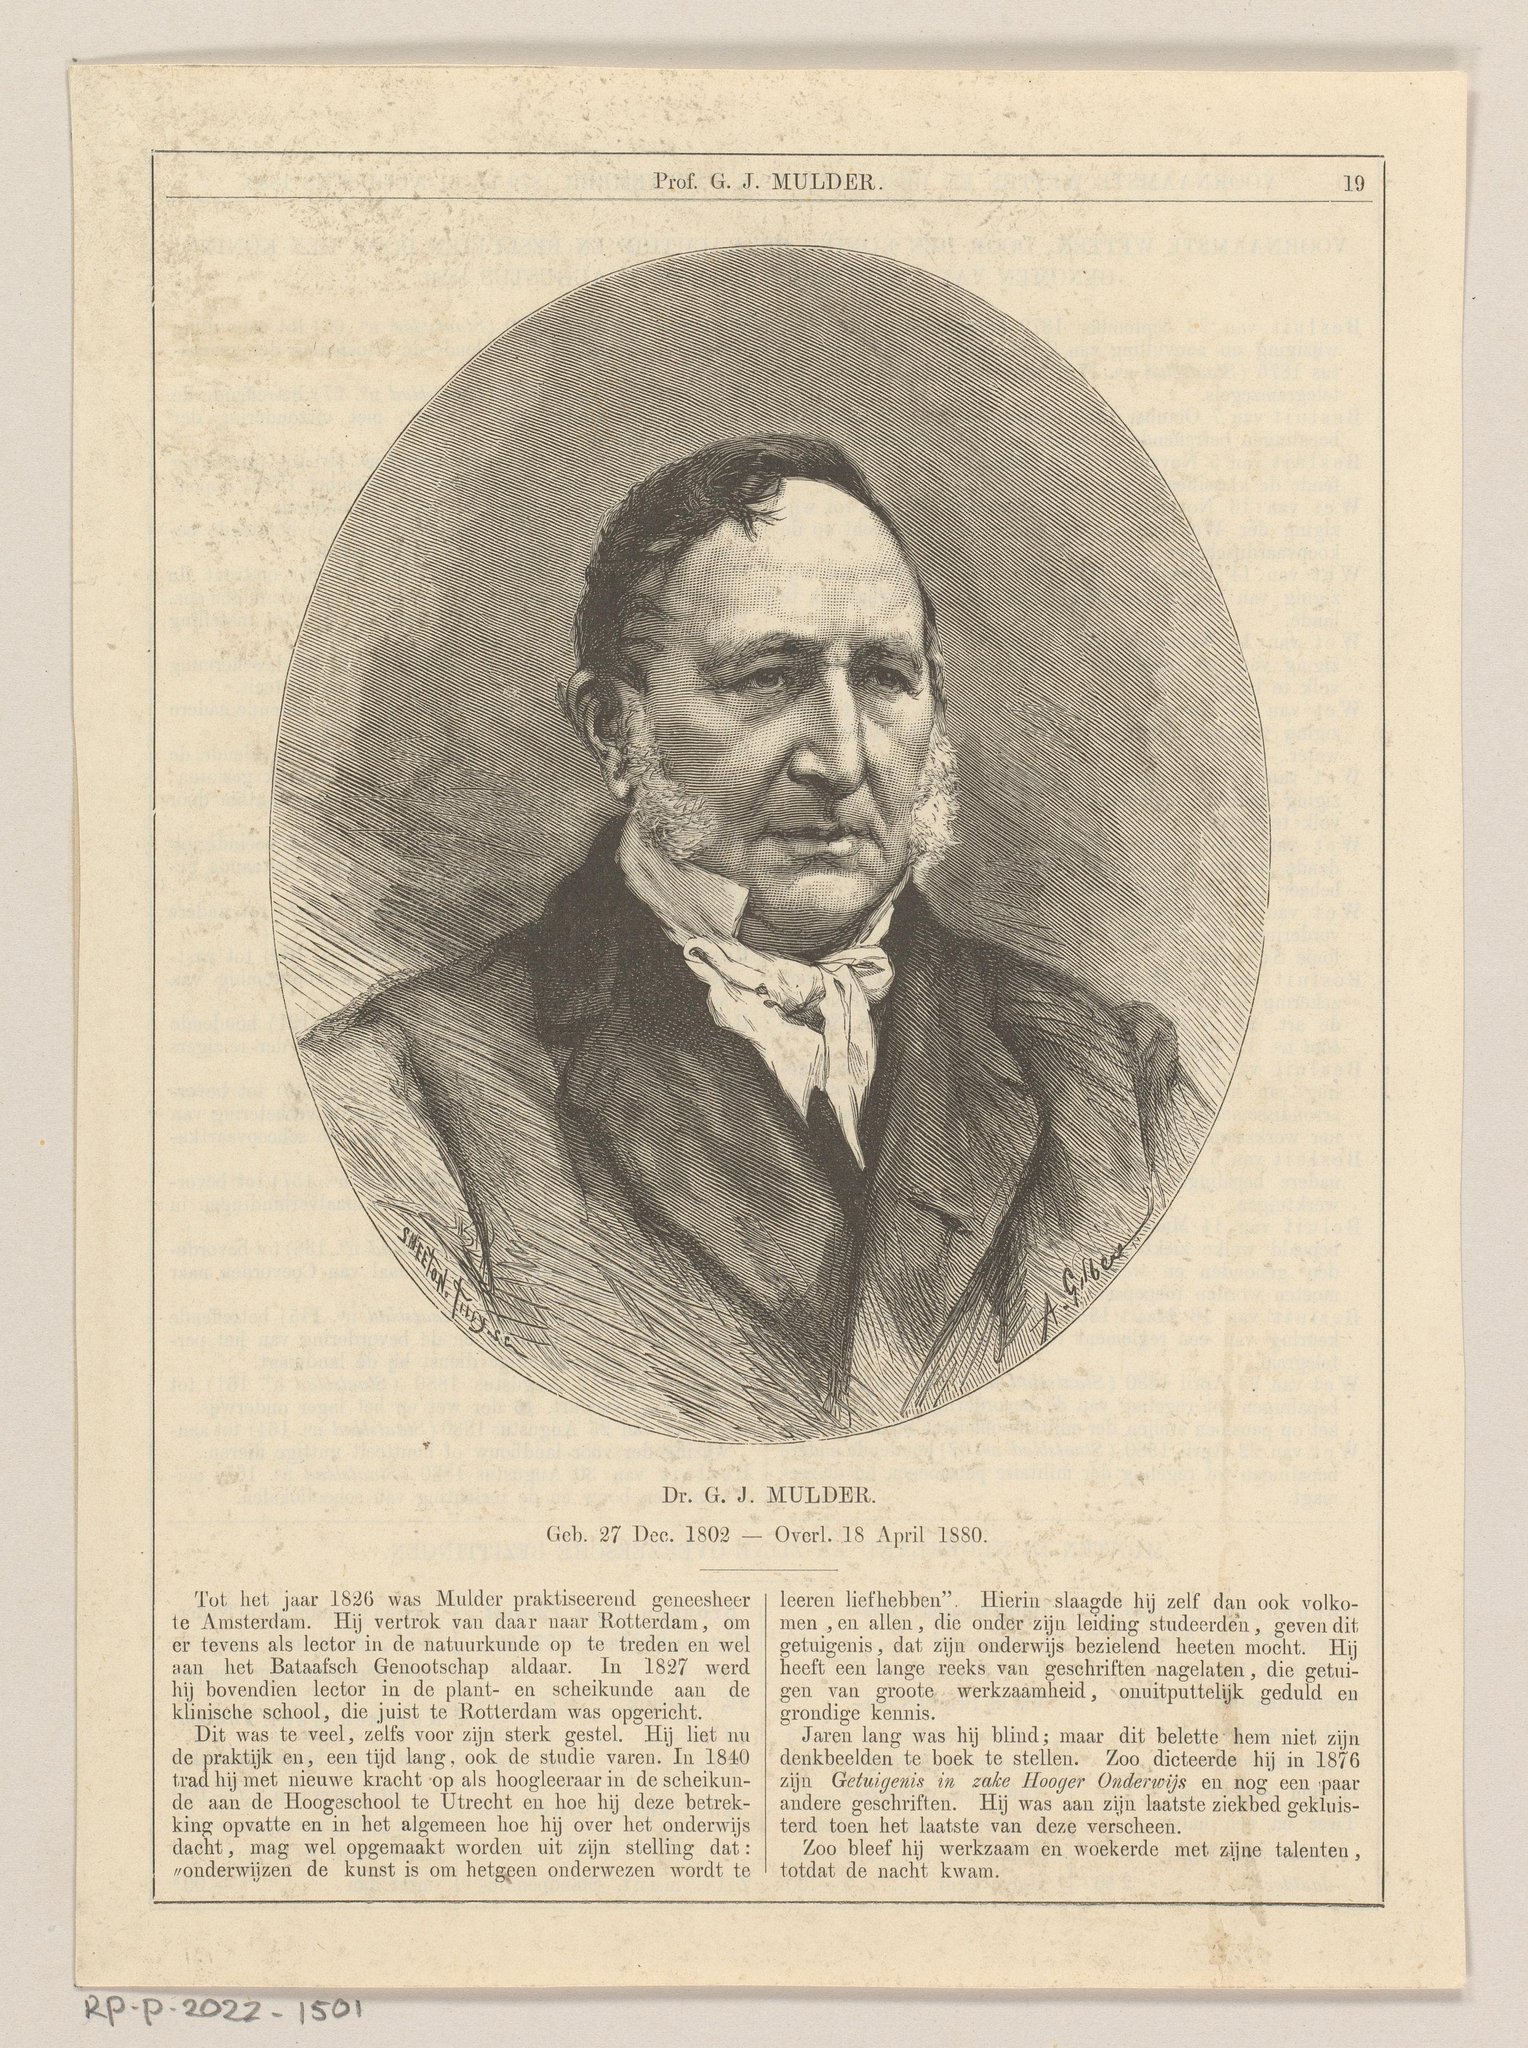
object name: print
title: Dr. G.J. Mulder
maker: a. gilbers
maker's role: print maker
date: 1880-1900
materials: paper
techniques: letterpress printing, engraving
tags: utrecht, historical persons, professor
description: Prent komt ook voor in: Eigen Haard 1 (1880), p. 181.